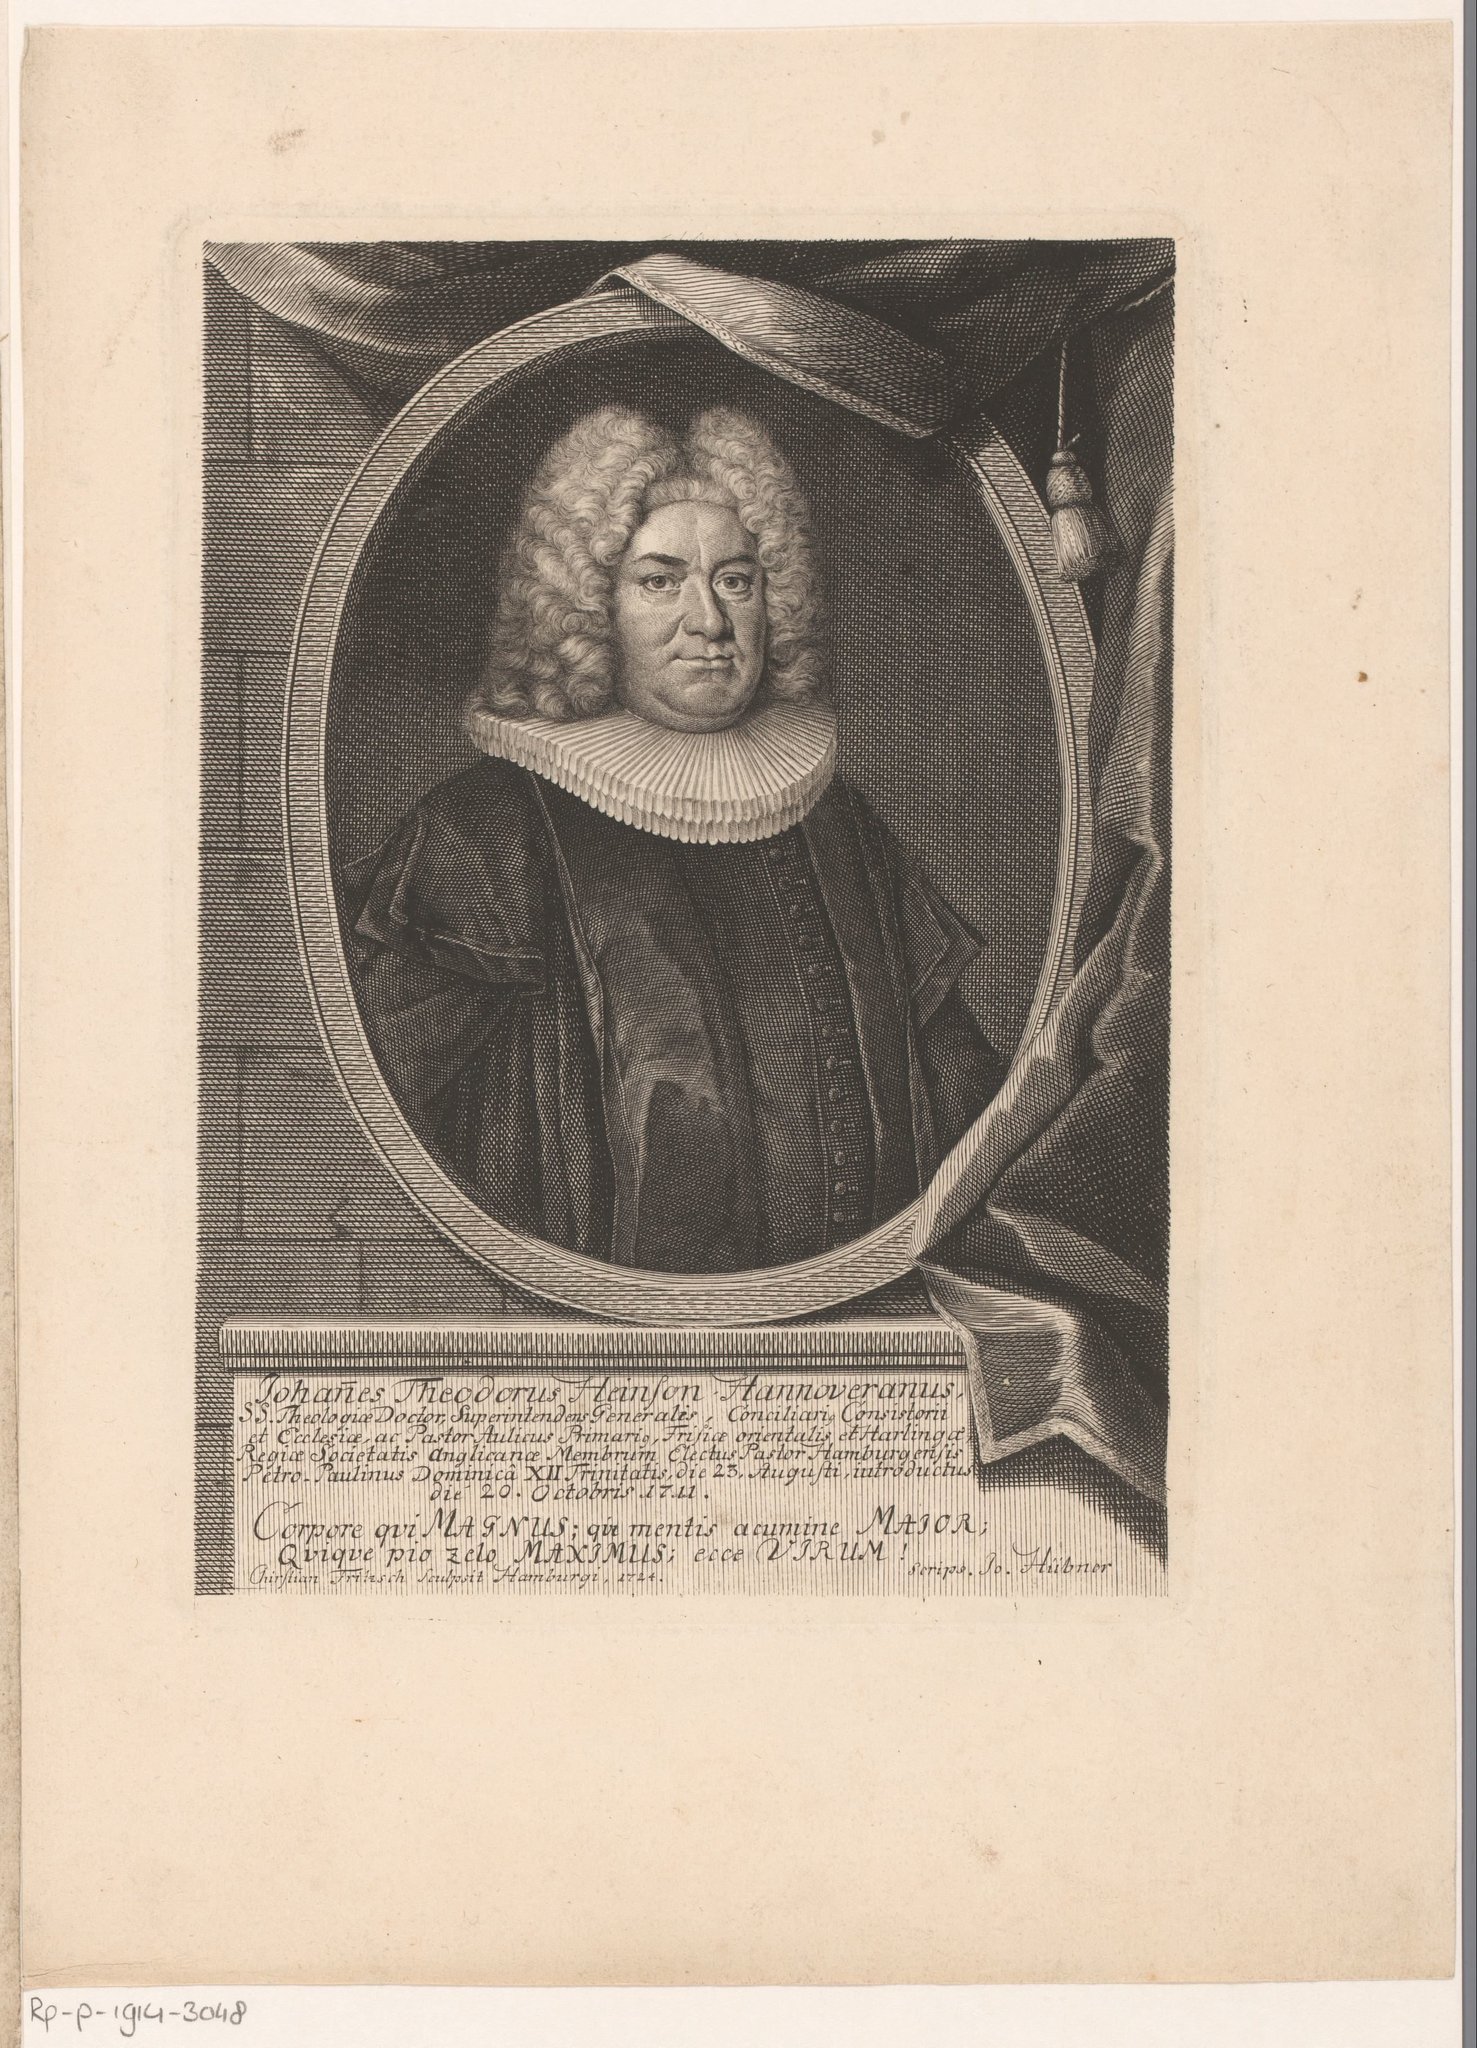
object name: print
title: Portret van Johann Theodor Heinson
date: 1724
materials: paper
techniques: engraving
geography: hamburg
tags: ornament ~ medallion, historical persons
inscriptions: collector's mark: Lugt 2228